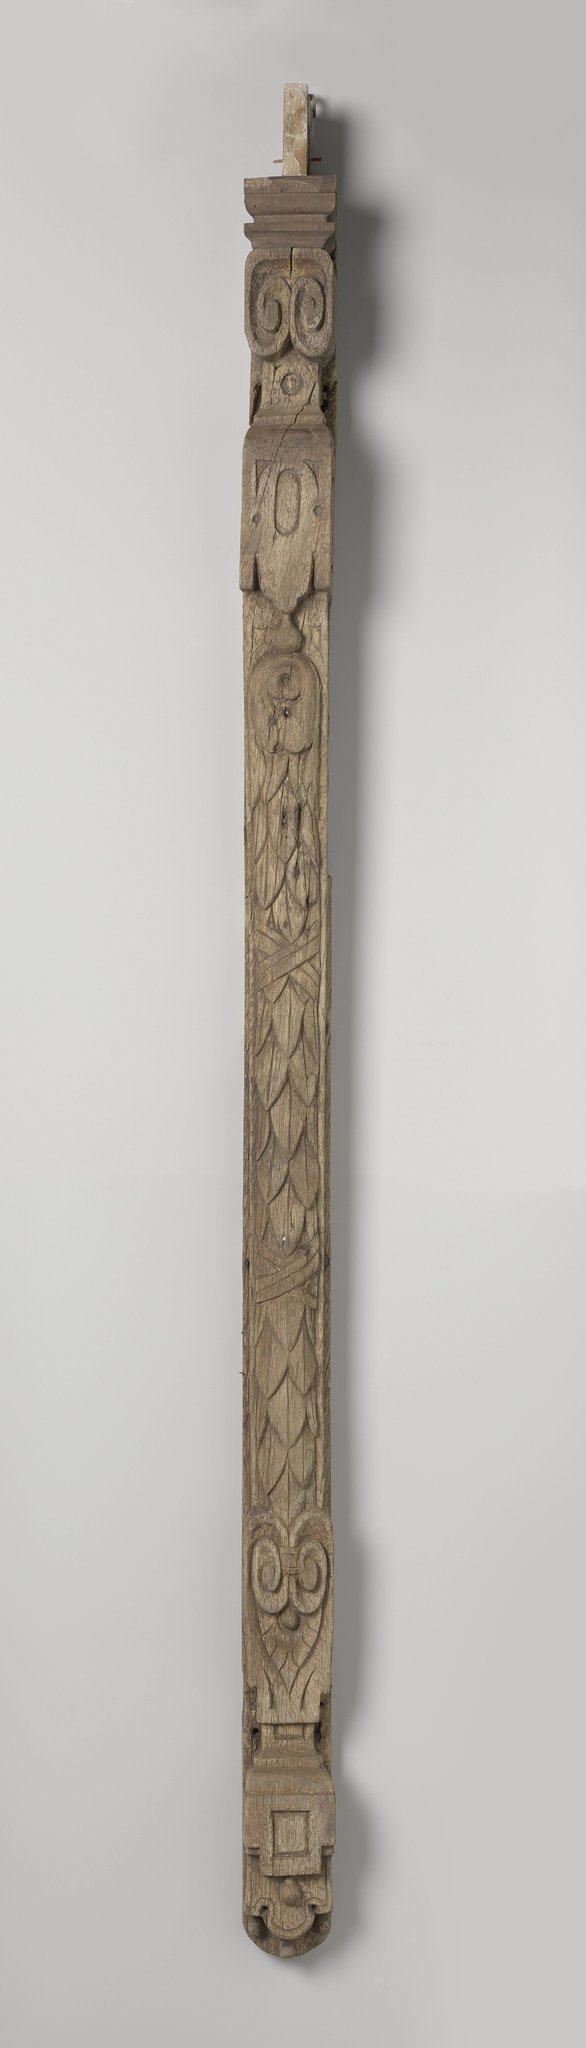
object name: stile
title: Gebeeldhouwde stijl van eikenhout, afkomstig uit het z.g. Huis van Alva, Warmoestraat te Amsterdam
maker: Anonymous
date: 1500-1699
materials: wood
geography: northern netherlands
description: Gebeeldhouwde eikenhouten stijl zonder afwerking, afkomstig uit het z.g. Huis van Alva, Warmoestraat te Amsterdam. In totaal gaat het om twee consoles, drie brede en drie smalle stijlen (BK-KOG-755-A t/m G). Zie tevens BK-KOG-754-1 t/m 7, dit zijn 6 beschilderde stijlen die uit hetzelfde huis afkomstig zijn.